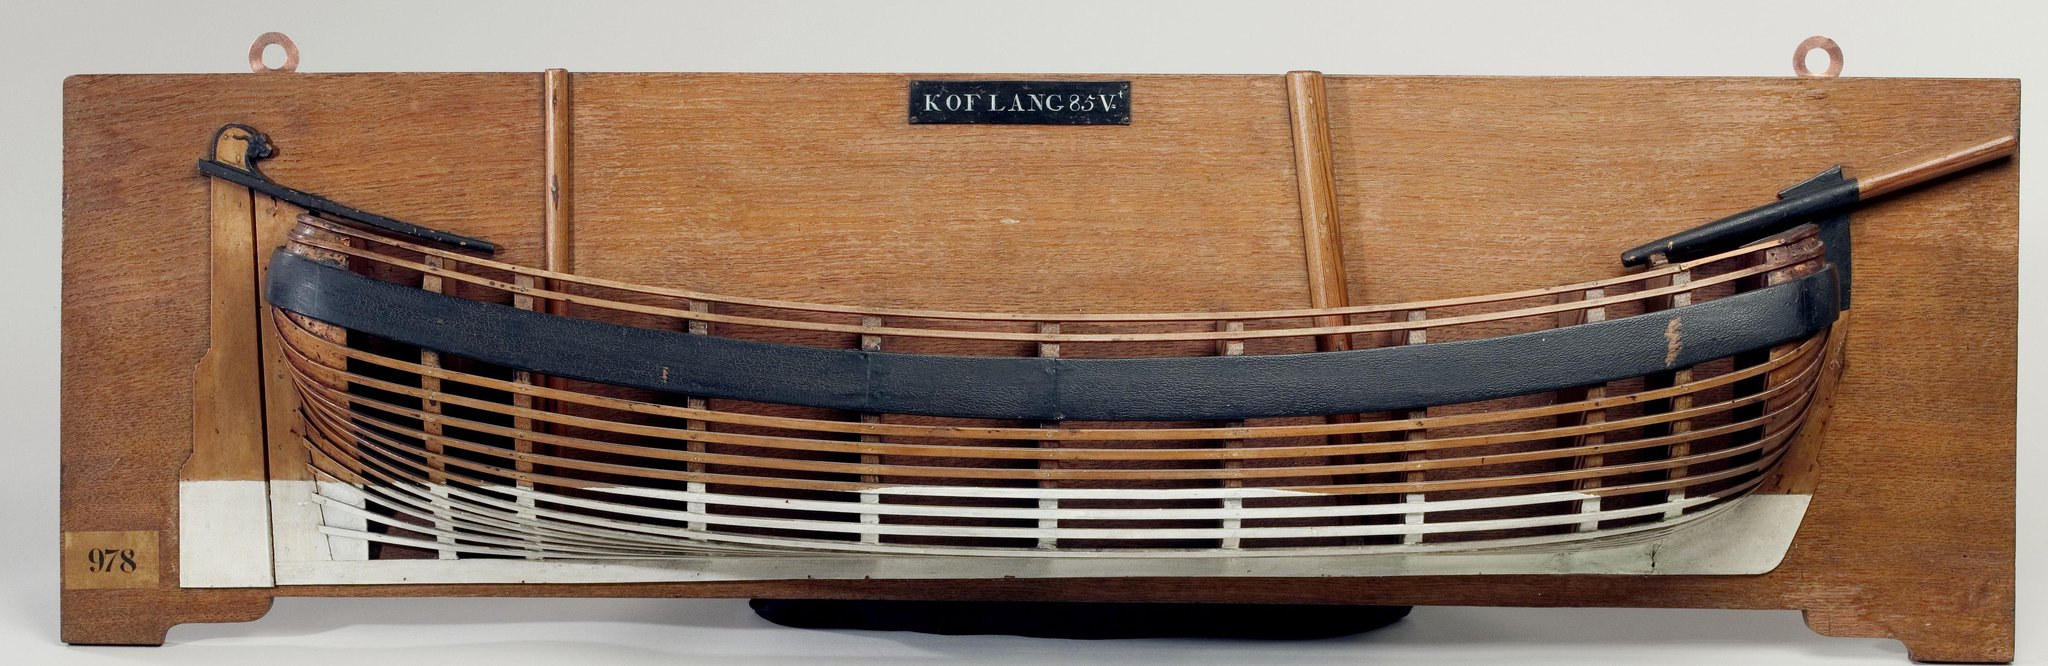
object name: builder's model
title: Half Model of a Koff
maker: Anonymous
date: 1780-1820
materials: wood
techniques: polychromy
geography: netherlands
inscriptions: inscription, top centre, on a rectangular black label: ‘KOF LANG 85 Vt’, inscription, on the back: ‘KOF L-85 V’, label, bottom left: ‘978’ former inventory label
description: Gepolychromeerd mallenmodel (stuurboord) van een tweemaster. Rond achterschip; recht roer met versierde roerkop en helmstok over het dek. De zeeg loopt op naar beide uiteinden, één barkhout. Rondspant met platte bodem. De voormast helt achterover, de boegspriet ligt naast de voorsteven. Schaal ca. 1:28 (schaal op model).